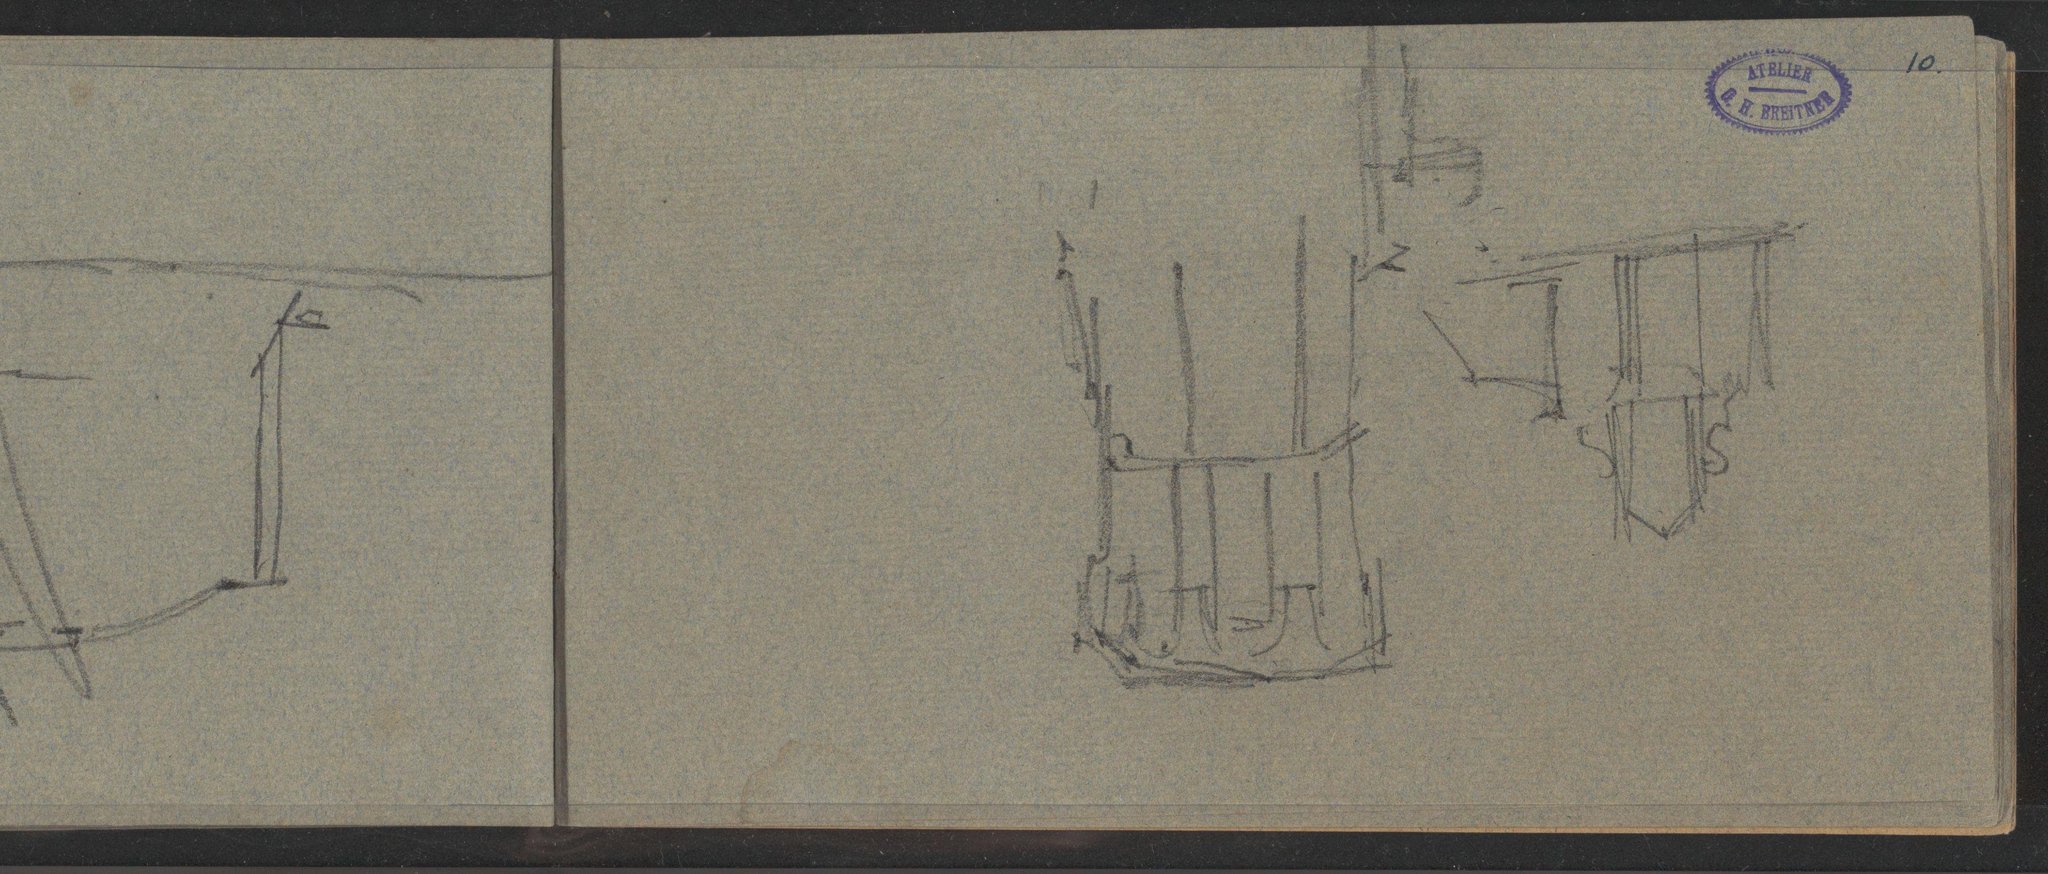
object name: sketchbook leaf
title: Landgoed Torenzicht te Poeldijk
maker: george hendrik breitner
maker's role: draughtsman, painter, print maker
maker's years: 1857-1923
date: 1883-1885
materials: paper, pencil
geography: the hague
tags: castle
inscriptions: workshop stamp: Lugt 291d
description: Blad 10 uit een schetsboek met 36 bladen.